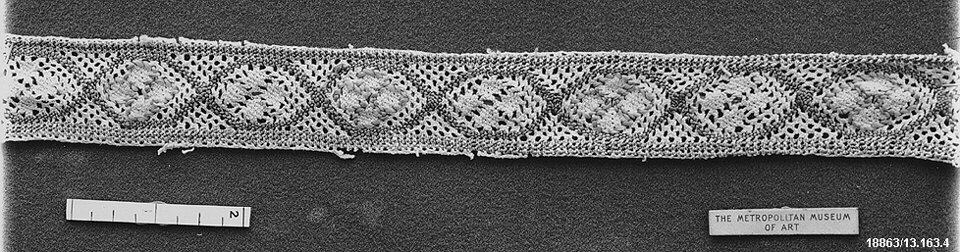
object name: insertion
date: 1601-1800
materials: linen, silk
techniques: lace